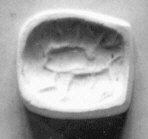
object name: stamp seal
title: Cushion seal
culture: cypriot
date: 1300-1101 BCE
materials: stone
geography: cyprus